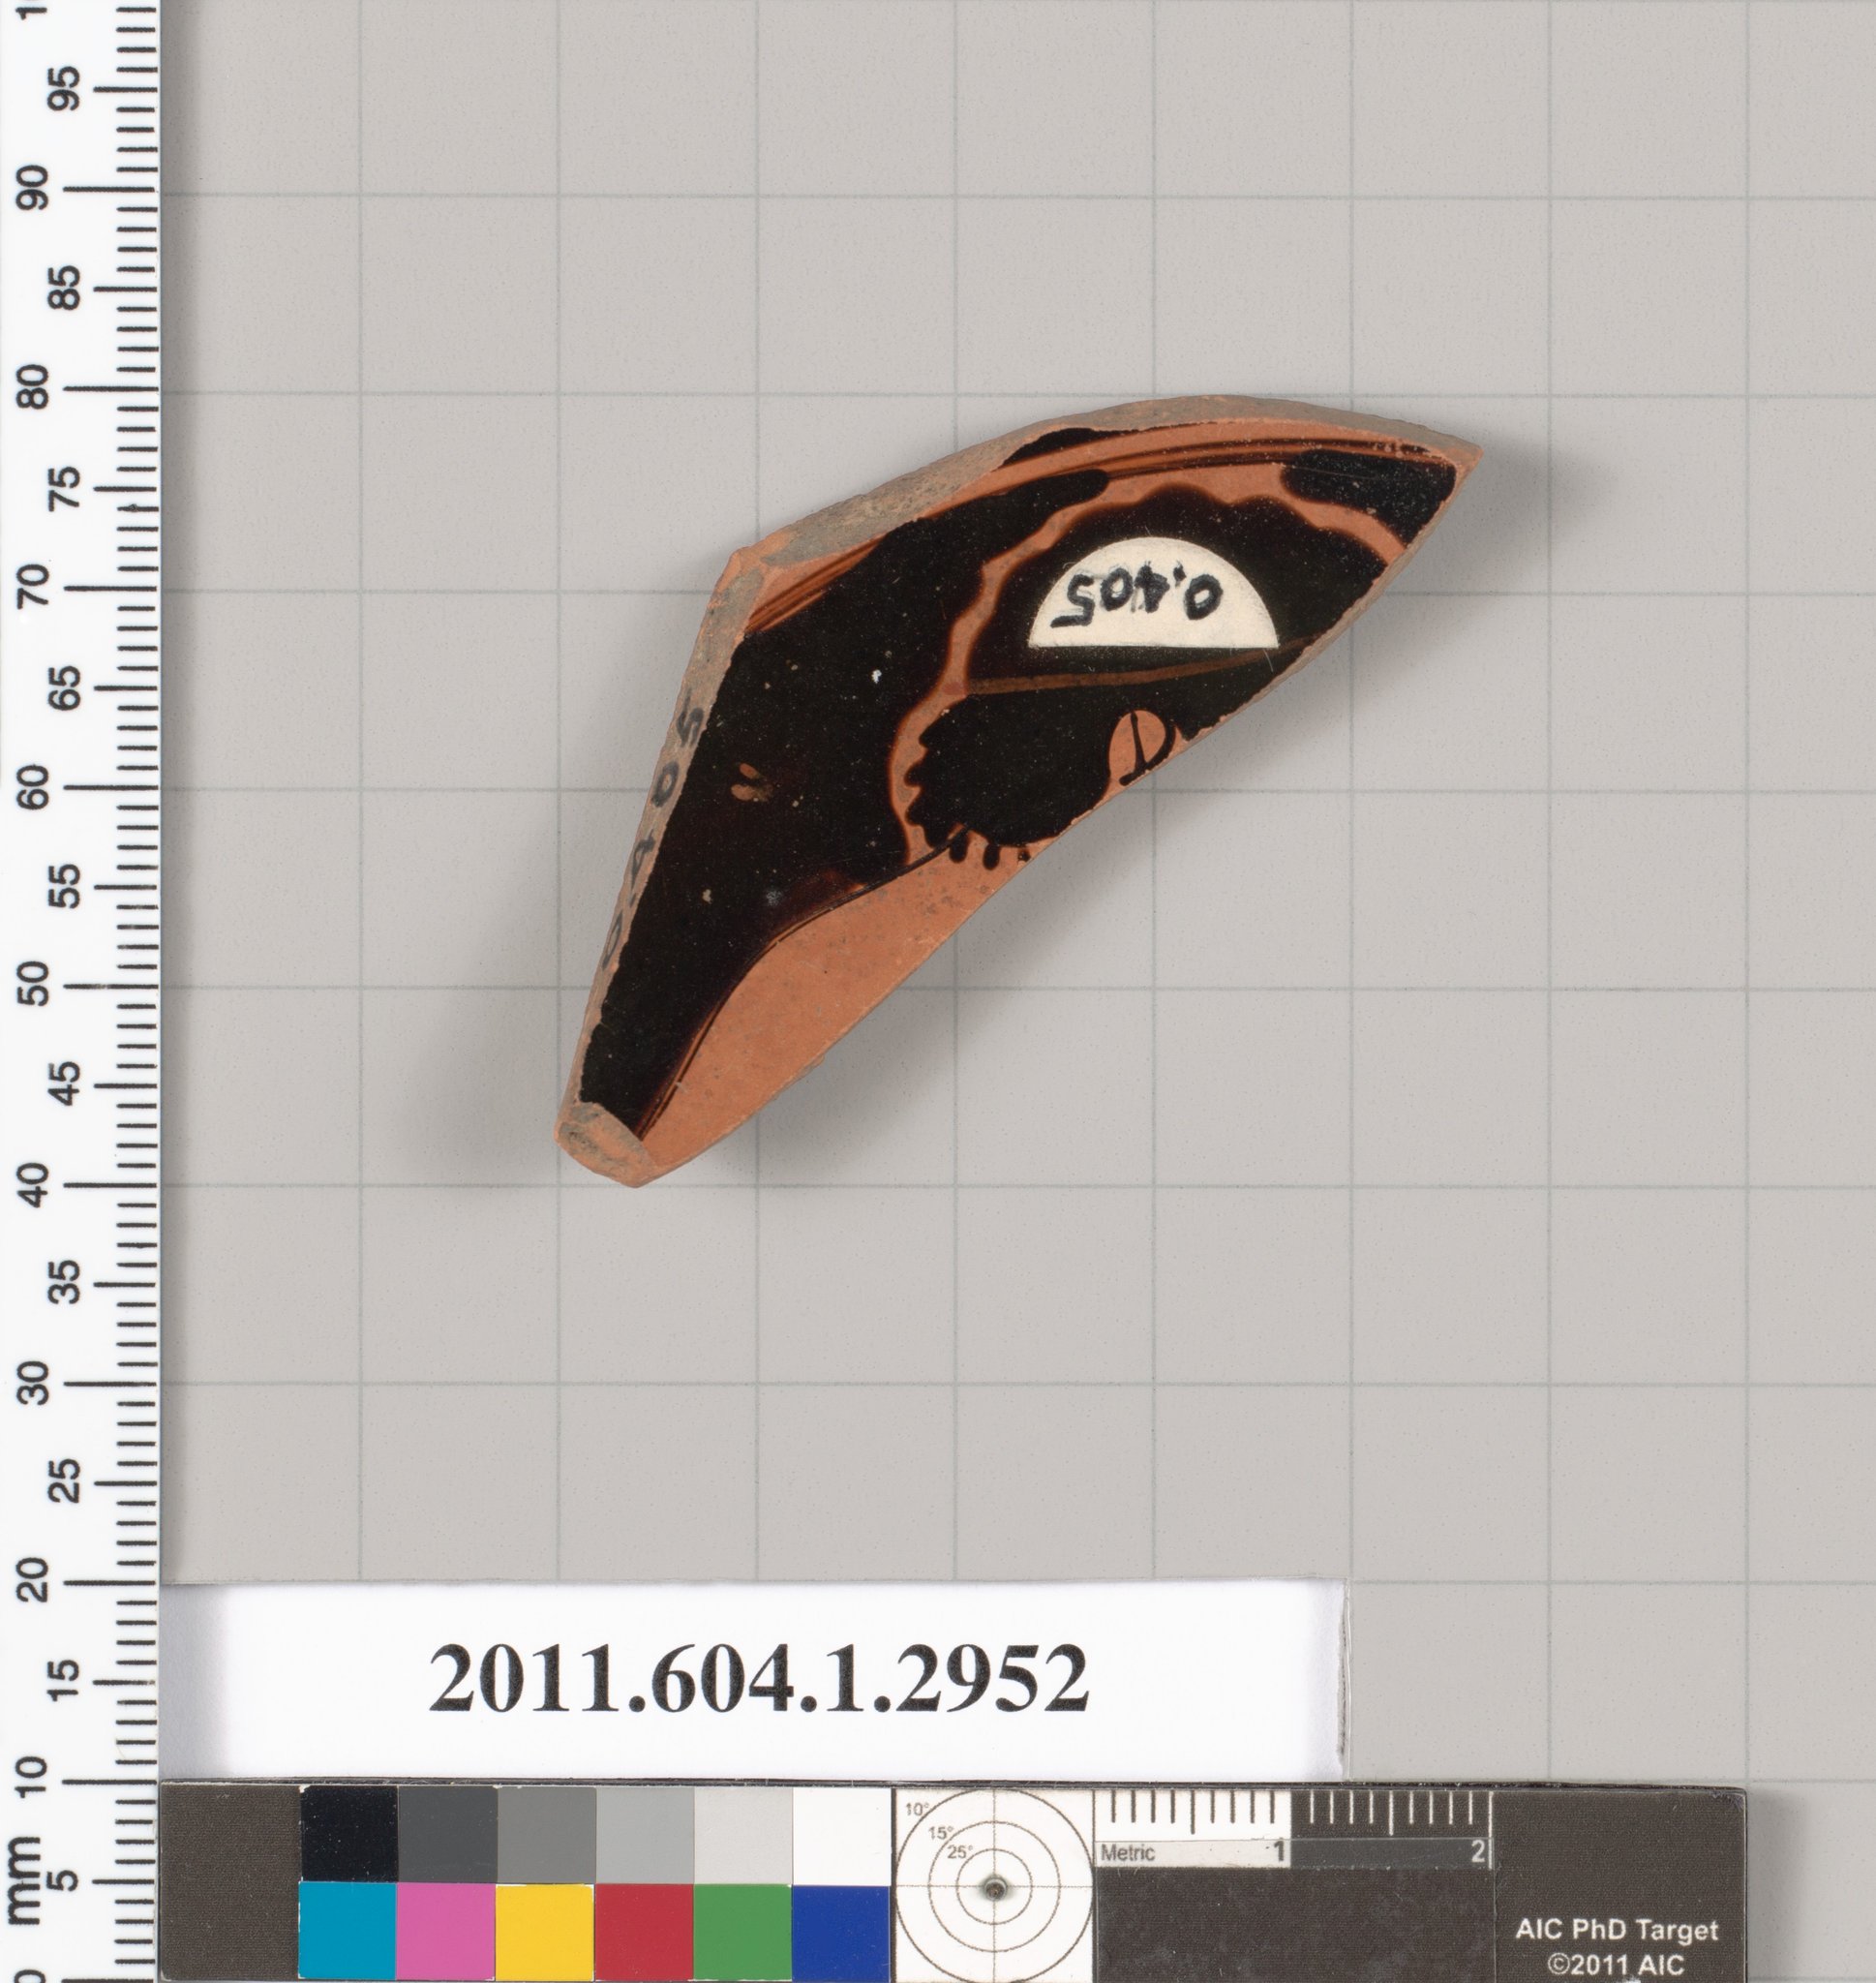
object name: kylix fragment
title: Terracotta fragment of a kylix (drinking cup)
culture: greek, attic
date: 520-500 BCE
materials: terracotta